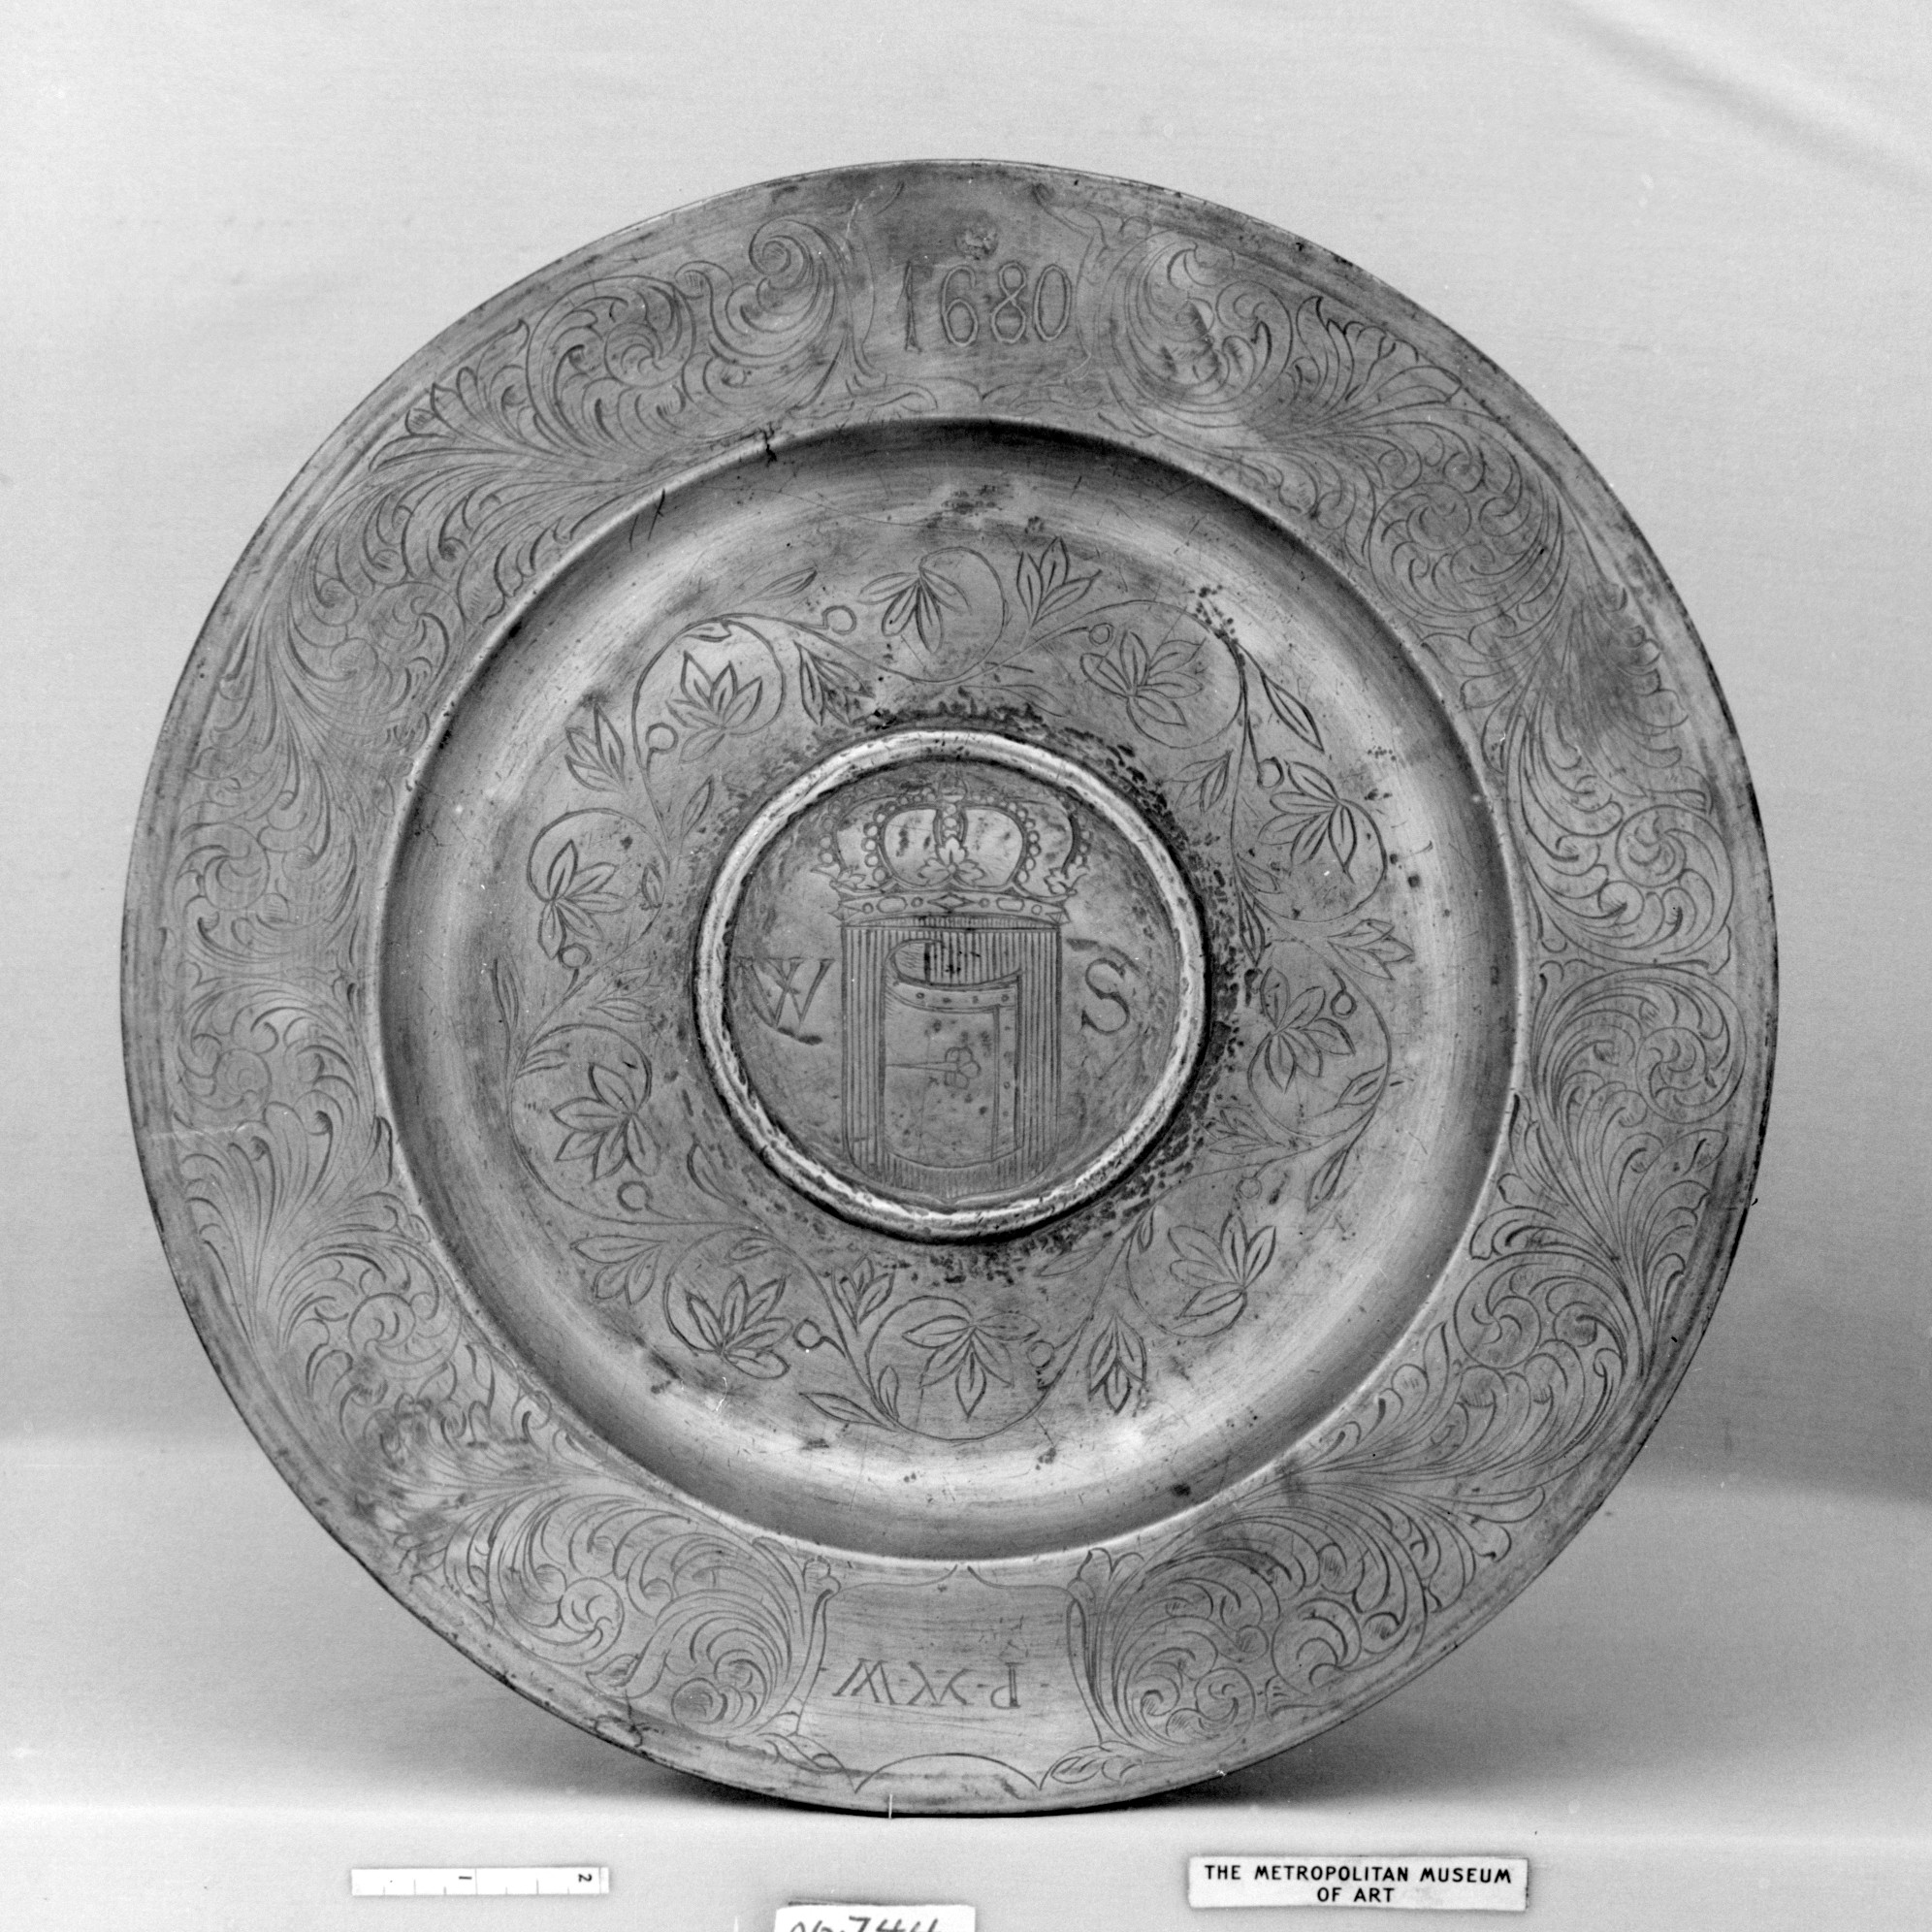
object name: platter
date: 1601-1700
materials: pewter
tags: coat of arms